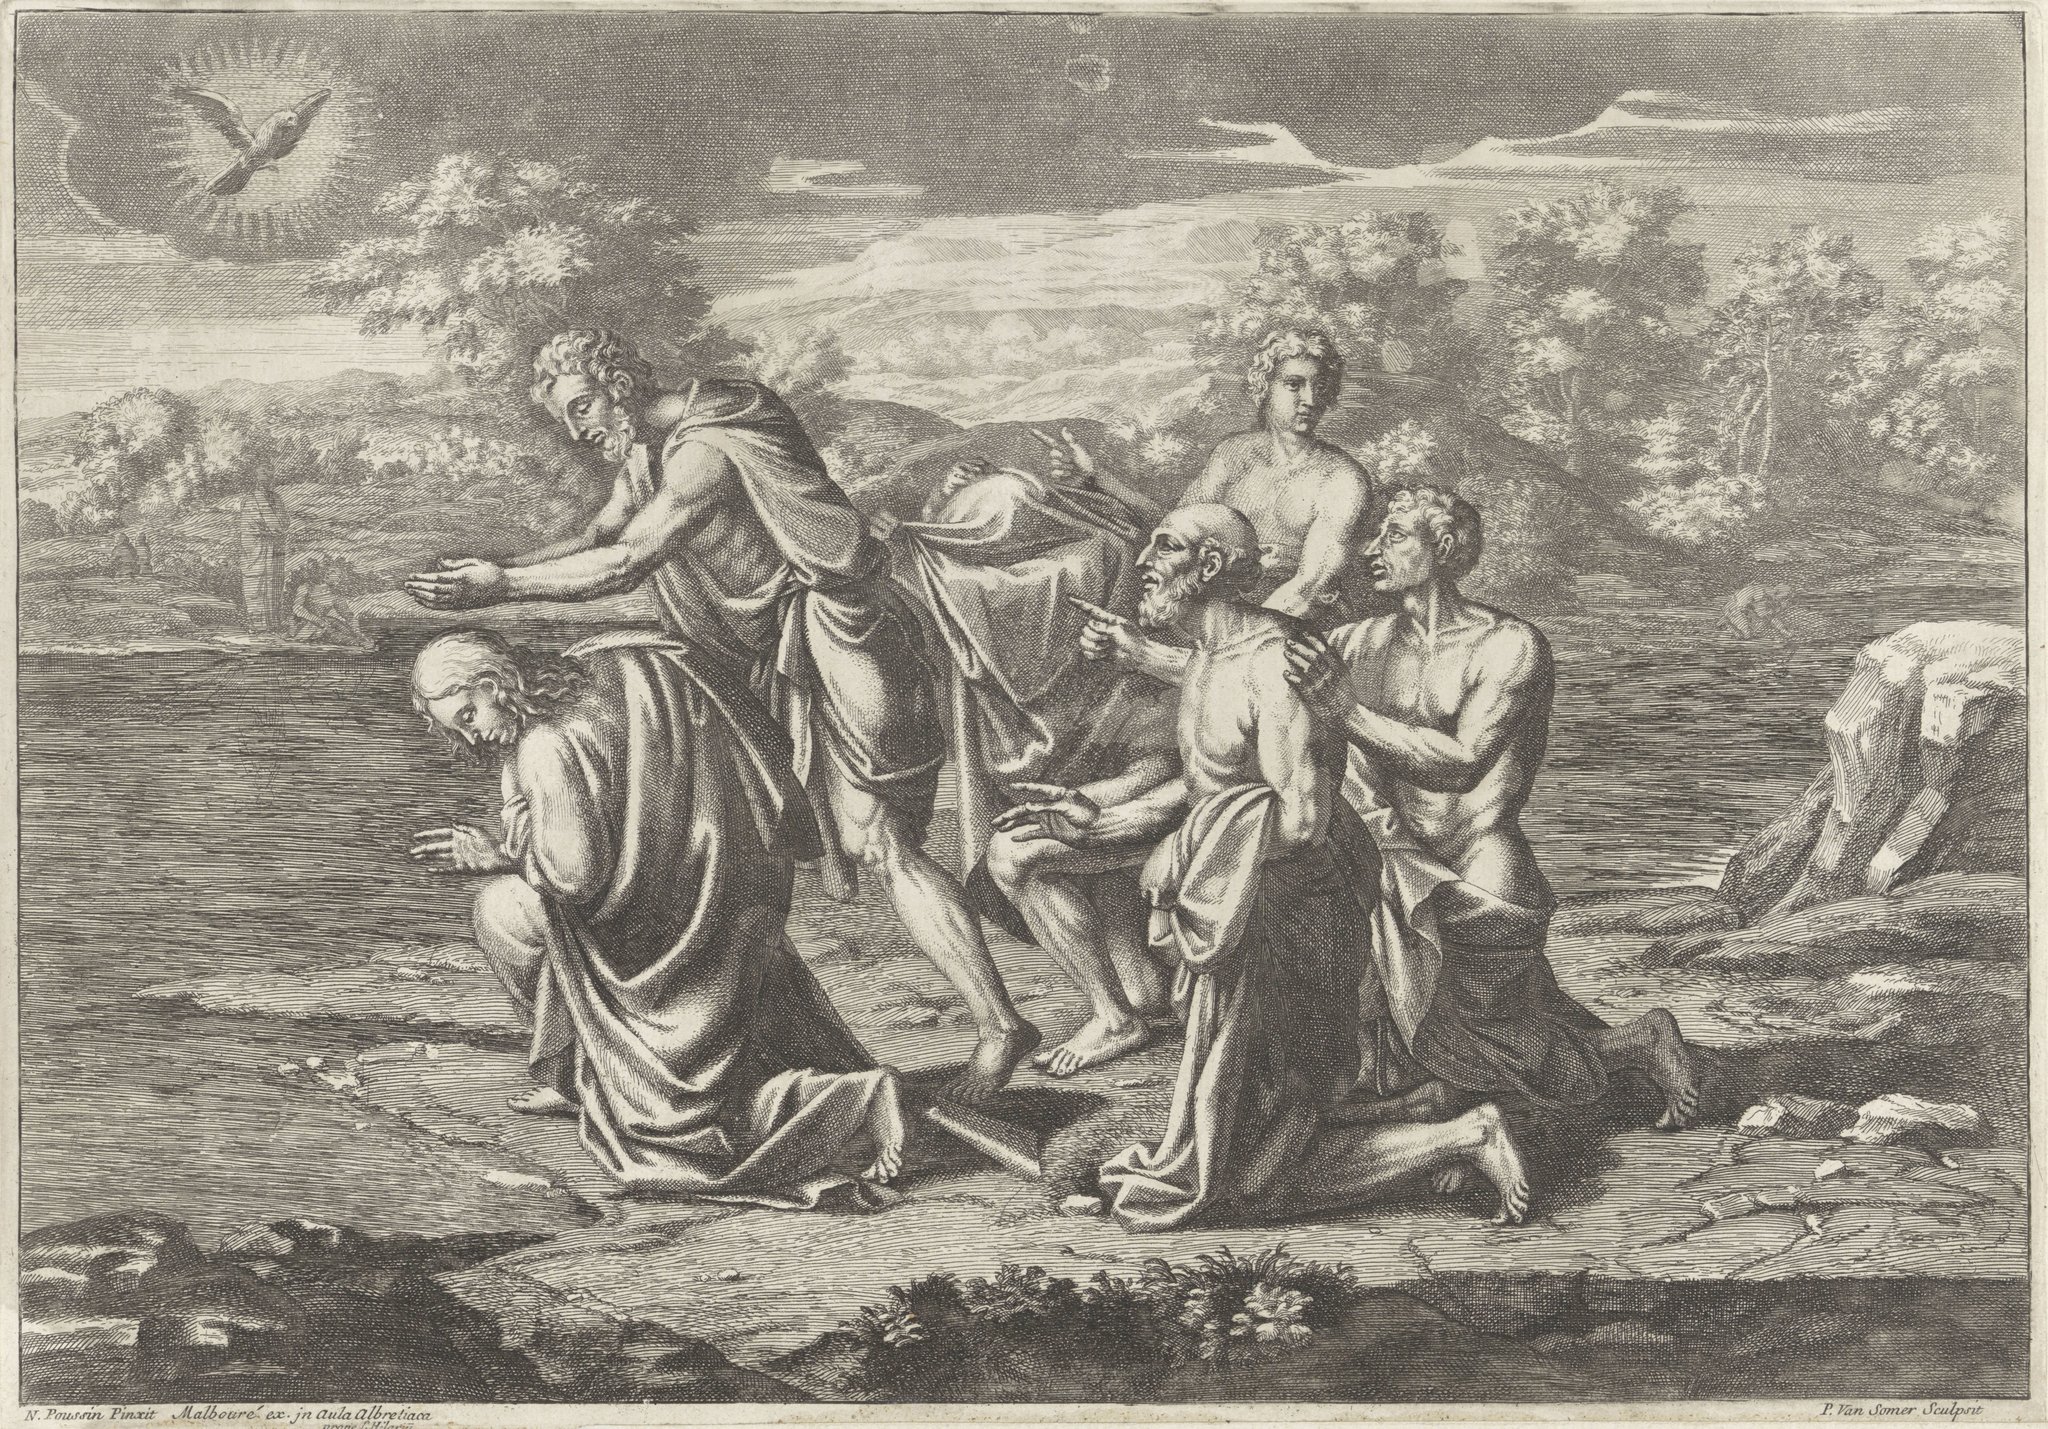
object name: print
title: Doop van Christus in de Jordaan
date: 1670-1697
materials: paper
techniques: engraving, etching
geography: paris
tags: baptism of christ in the river jordan: john the baptist pouring out water on christ's head: the holy ghost descends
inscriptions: collector's mark: Lugt 240, collector's mark: ‘No. 83’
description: Christus wordt door Johannes de Doper in de Jordaan gedoopt (Matteüs 3:13-17). Mannen die in geknielde houding wachten op hun eigen doop; zij wijzen naar de duif van de Heilige Geest boven het hoofd van Christus.